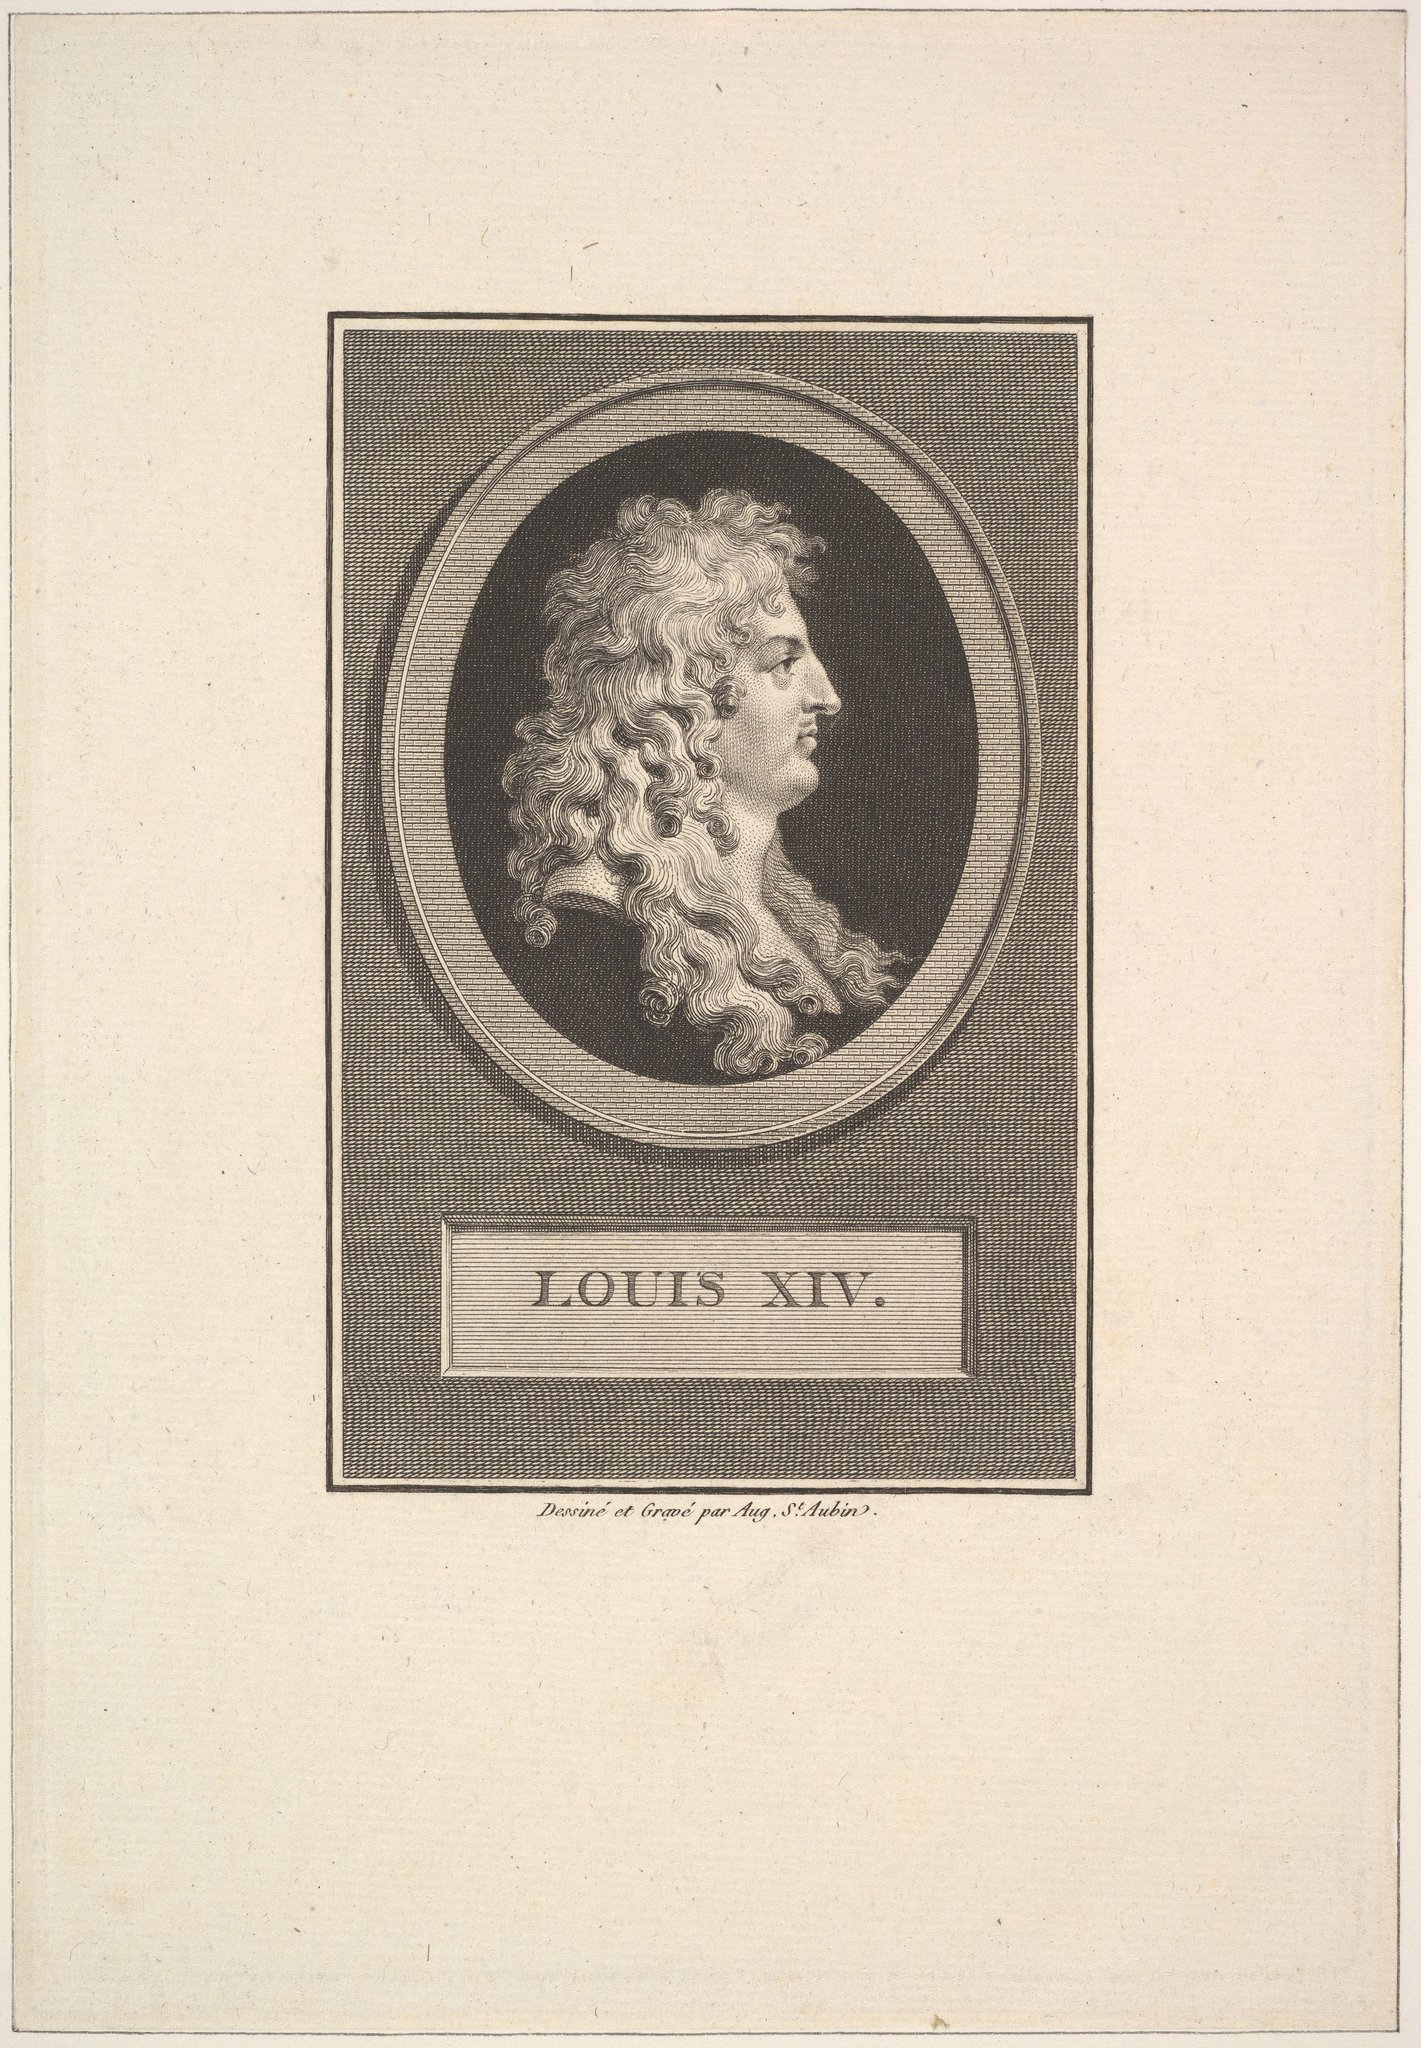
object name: print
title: Portrait of Louis XIV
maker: augustin de saint-aubin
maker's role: artist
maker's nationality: french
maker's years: 1736-1807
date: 1779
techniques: engraving, etching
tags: louis xiv